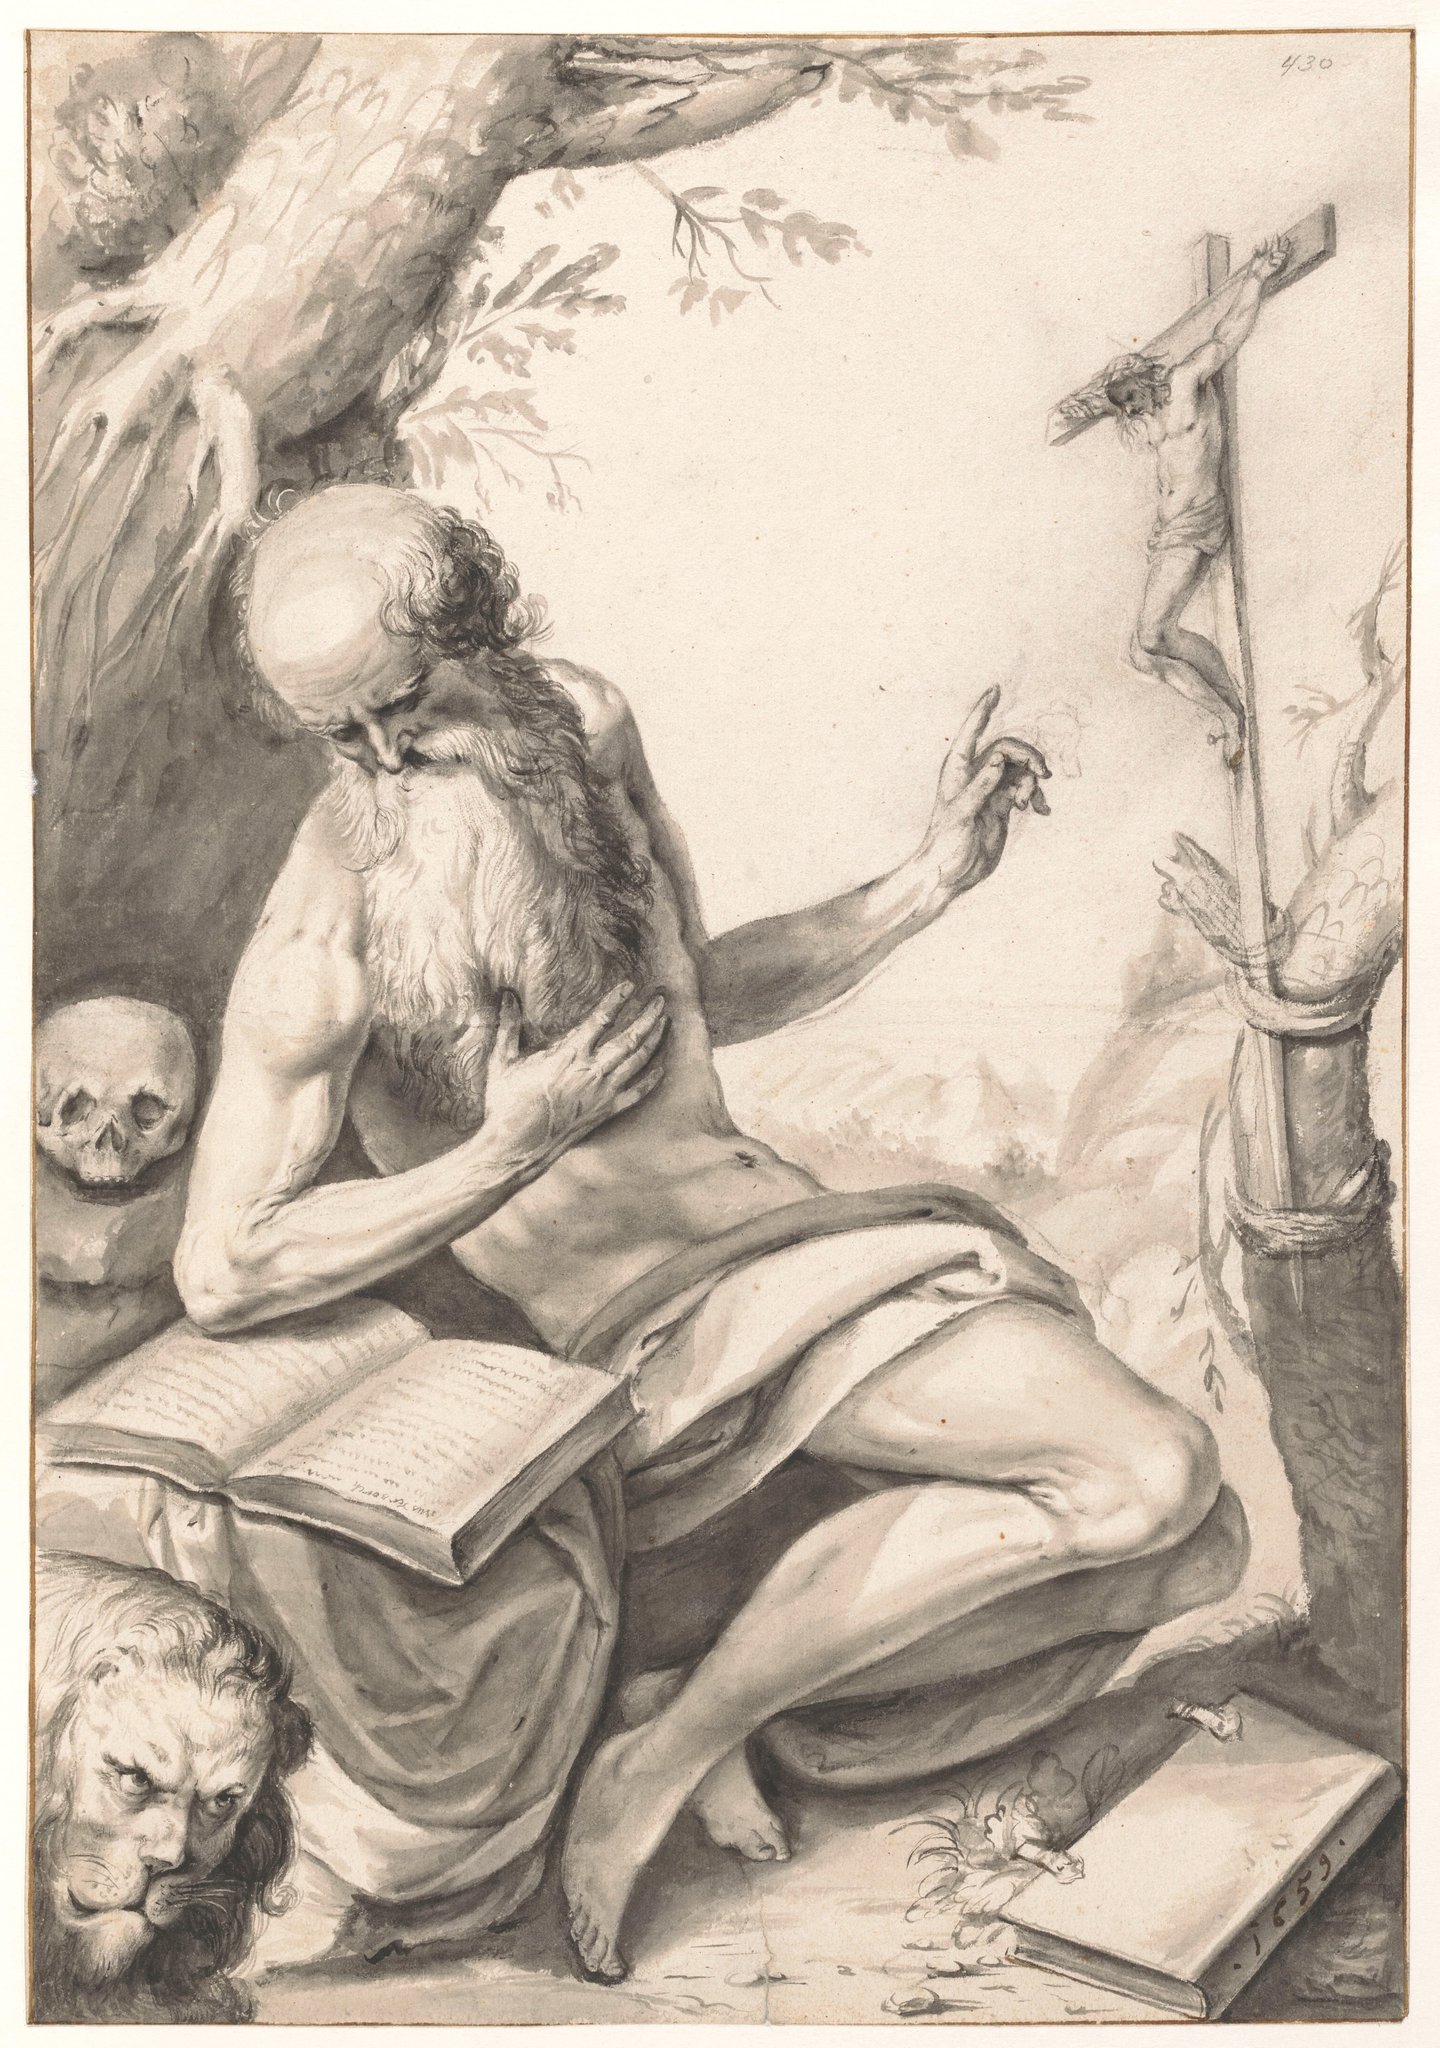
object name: drawing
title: De heilige Hieronymus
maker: moses ter borch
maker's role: draughtsman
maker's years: 1645-1667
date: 1659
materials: chalk, ink, paper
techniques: brush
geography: zwolle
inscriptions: signature and date: ‘Mosus ter Borch; 1659’, annotation: ‘B.266 / Goltzius Palma’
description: Naar gravure van H. Goltzius naar Jacopo Palma (il Giovane).